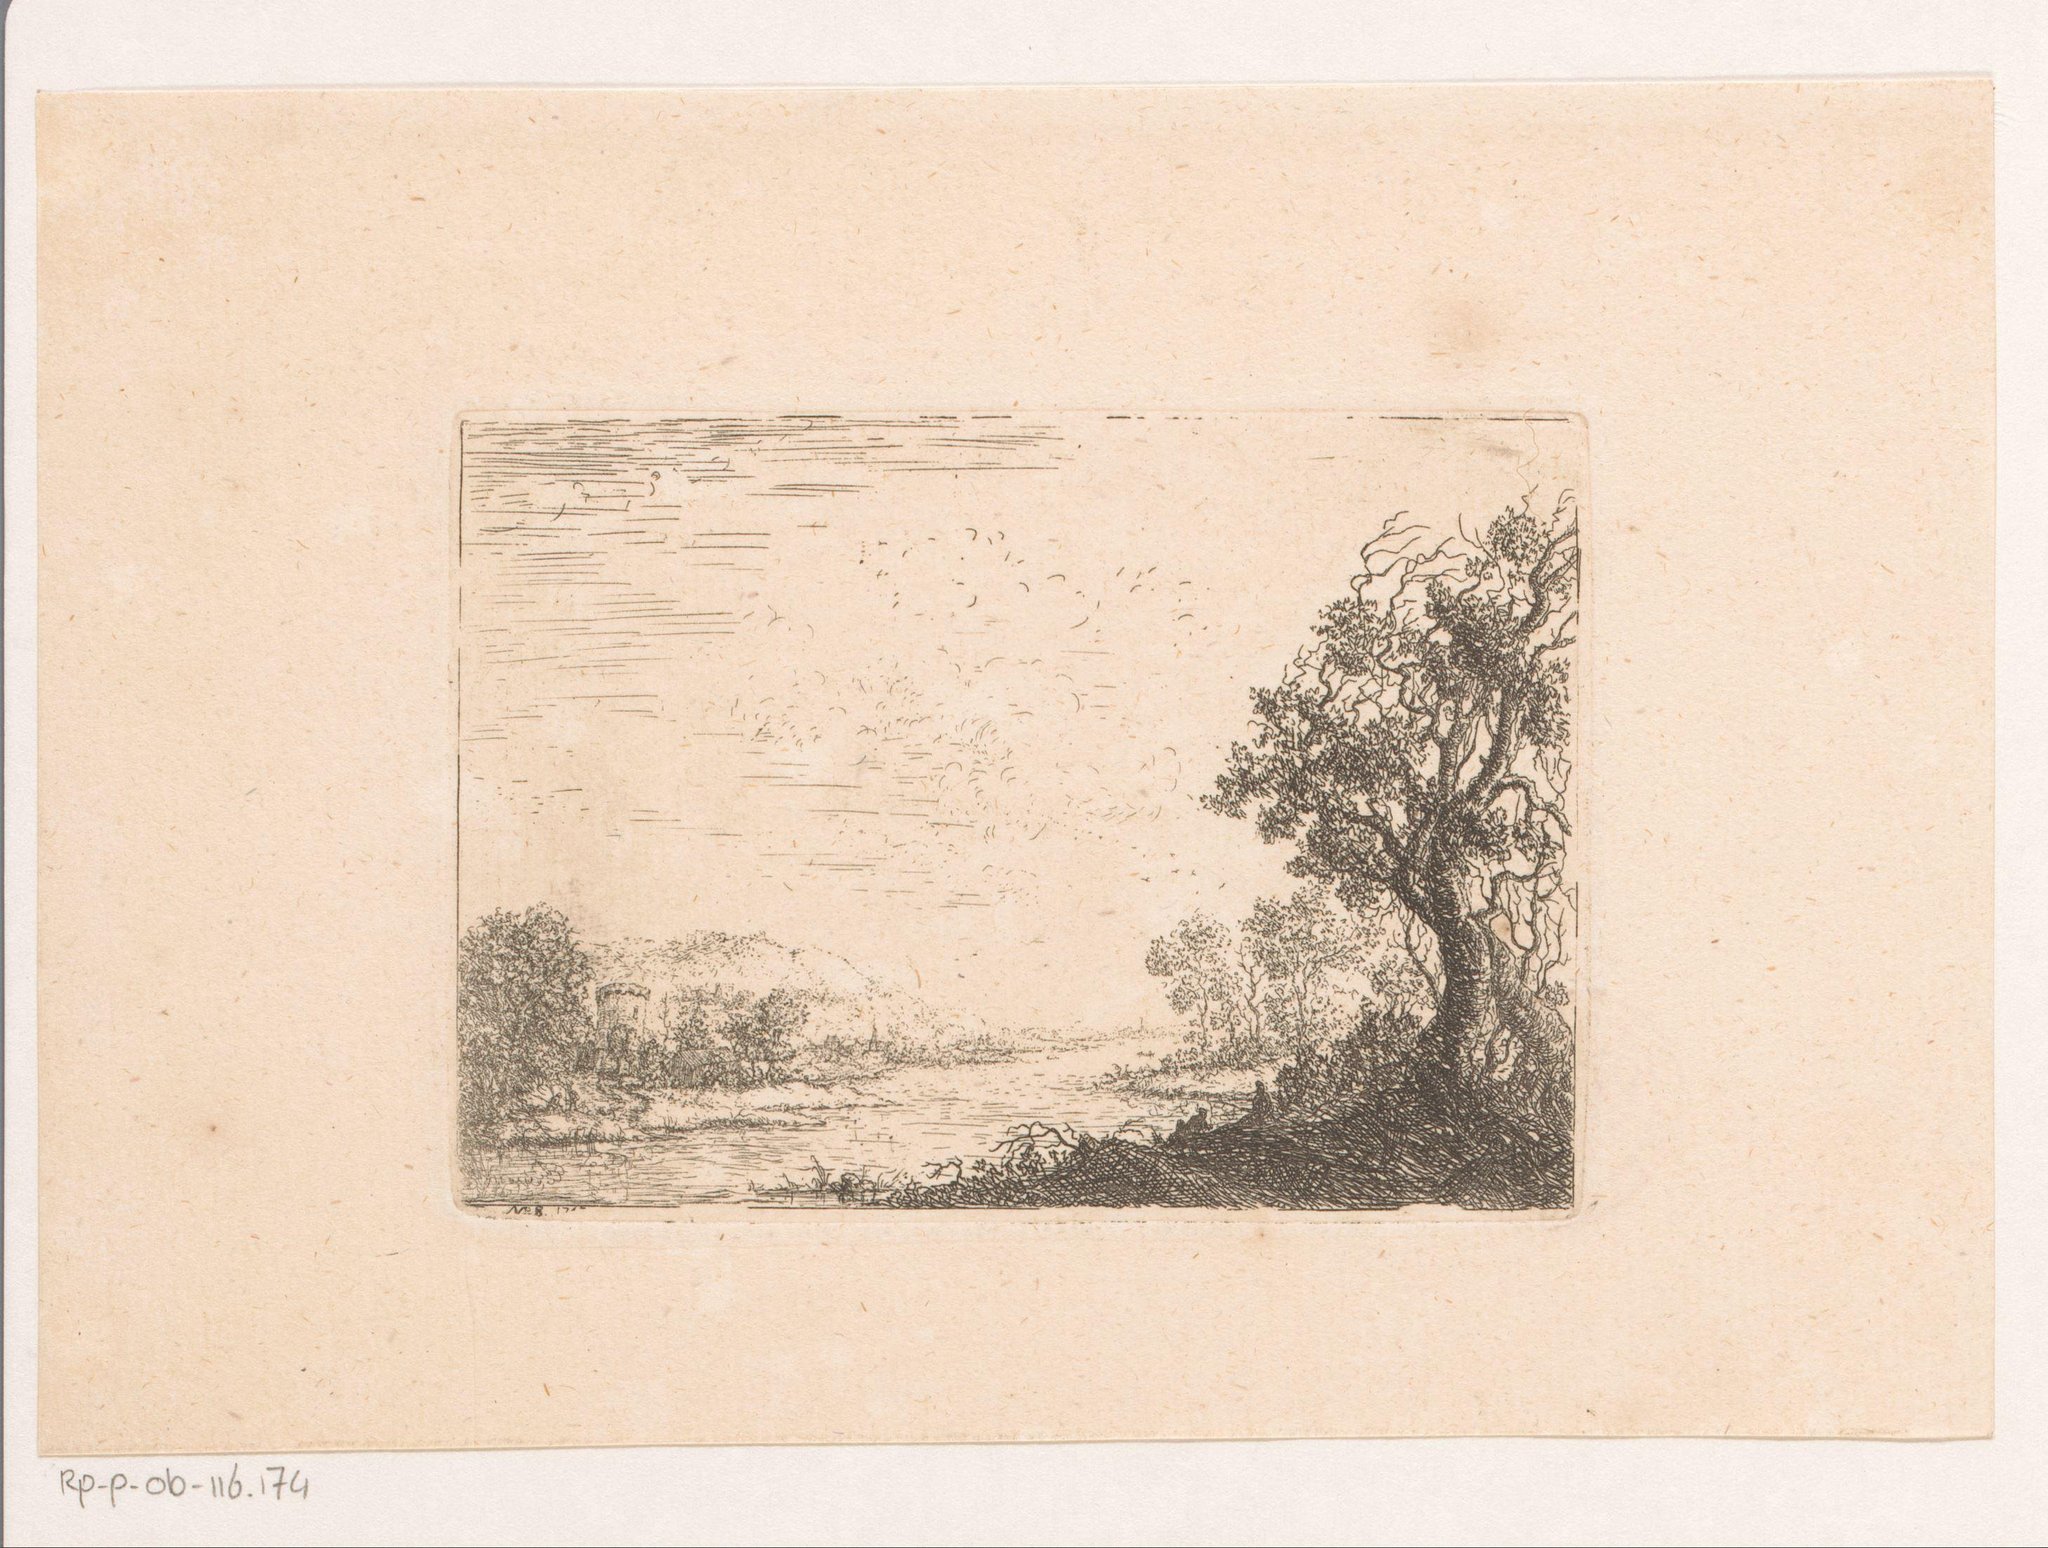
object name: print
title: Rivierlandschap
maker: christian ludwig von hagedorn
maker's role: painter, print maker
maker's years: 1712-1780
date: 1745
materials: paper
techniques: etching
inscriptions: collector's mark: Lugt 240